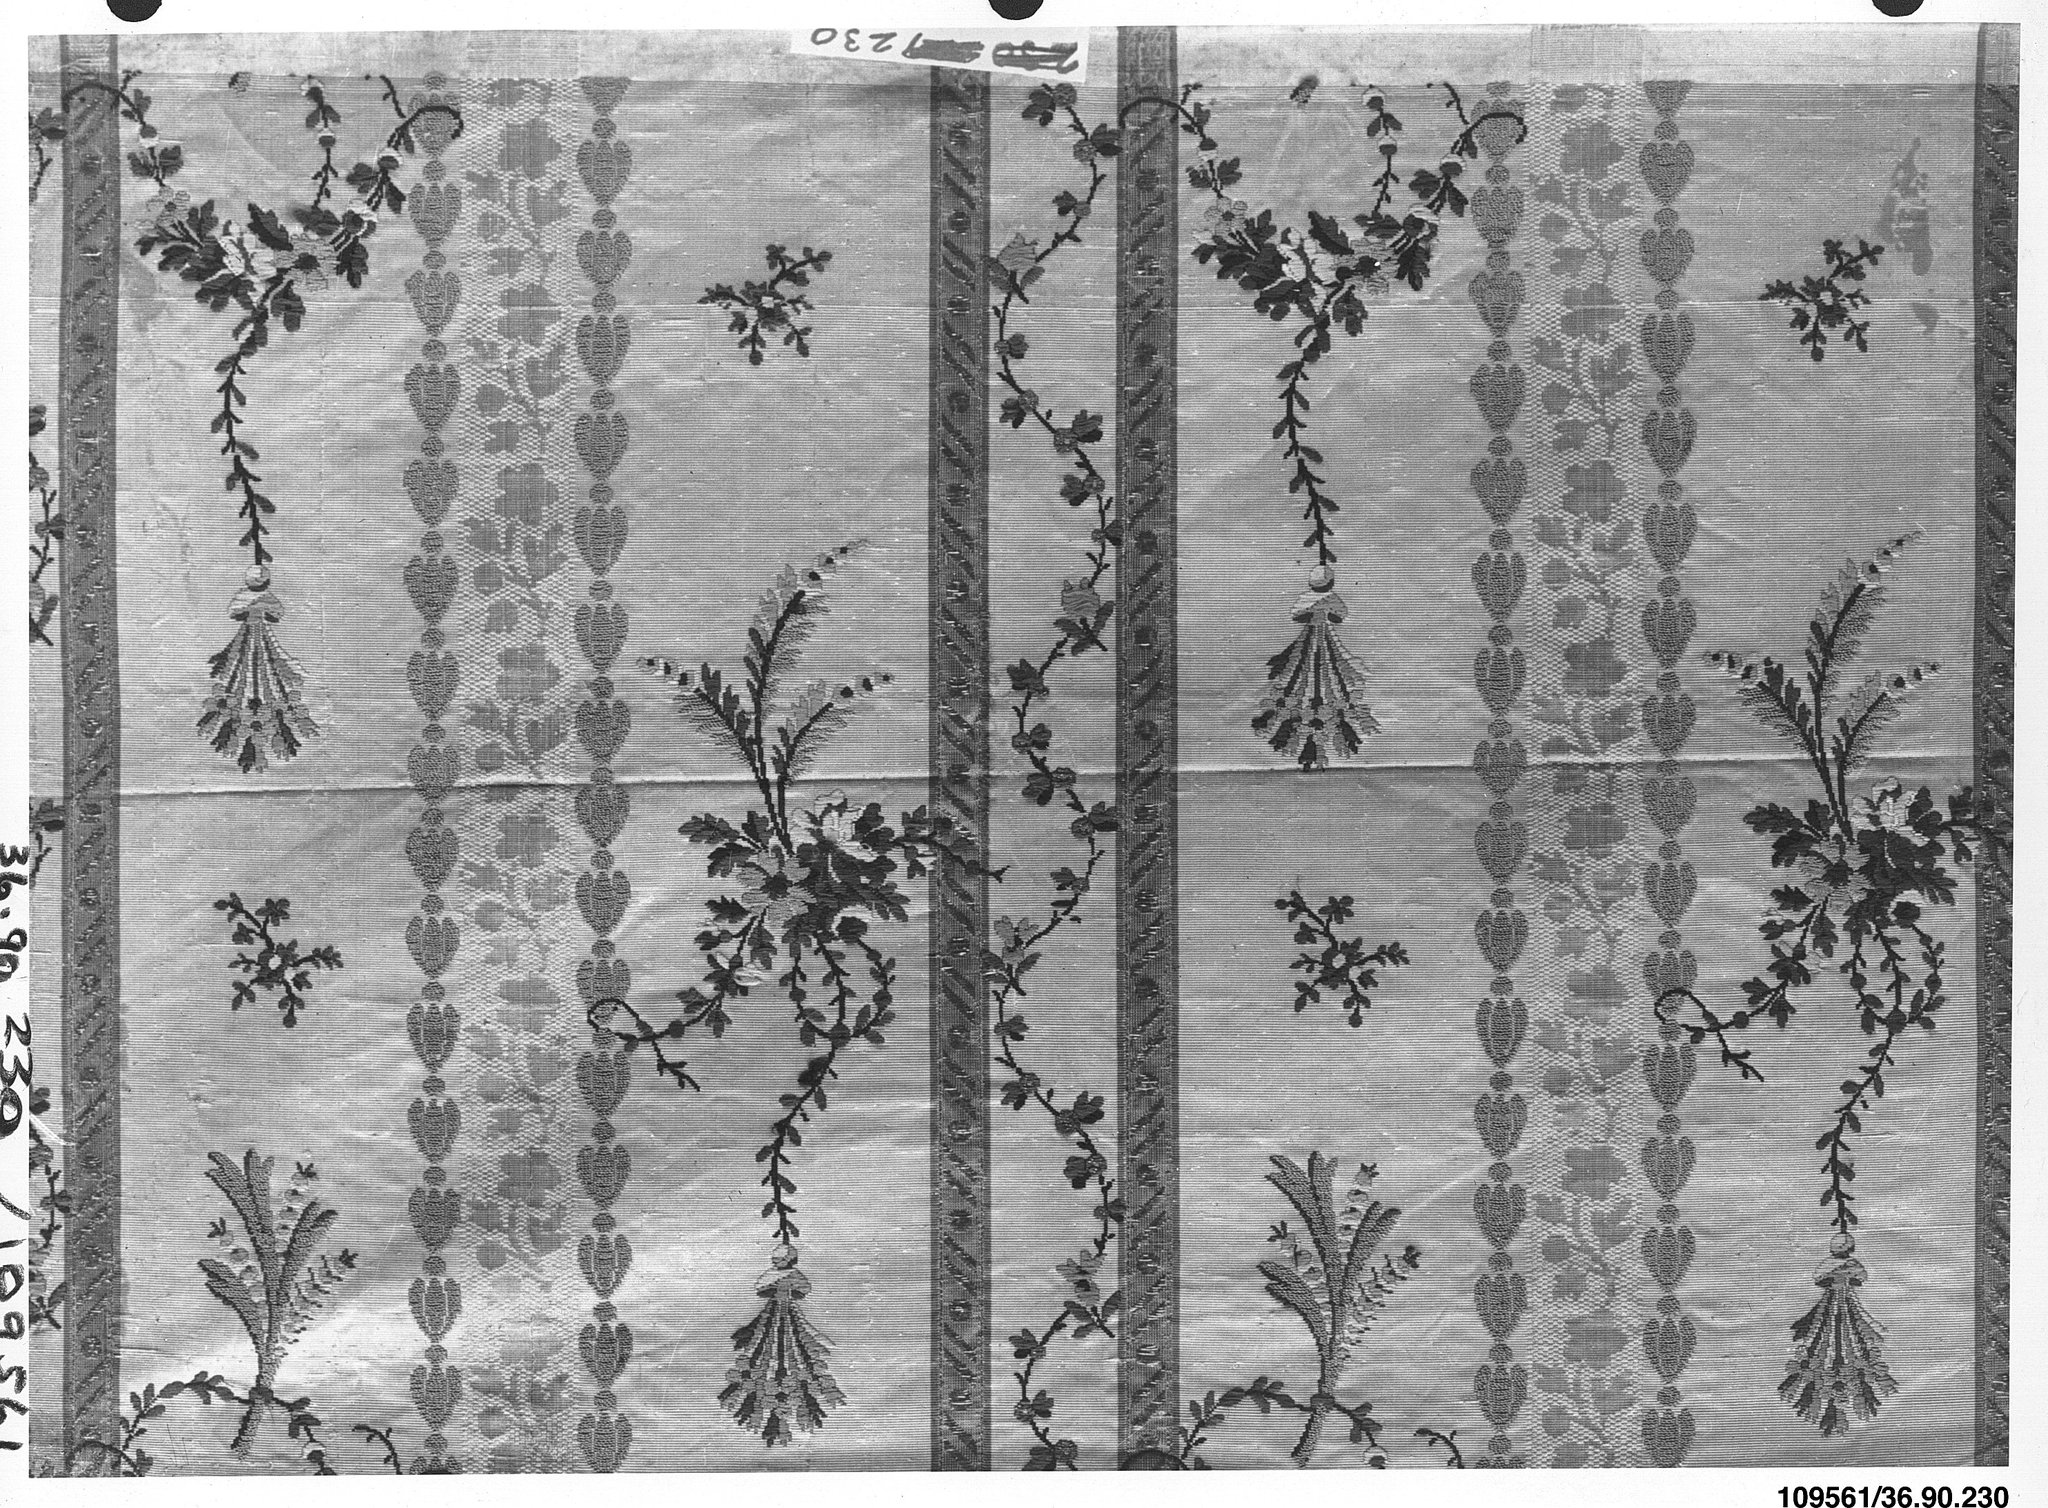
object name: piece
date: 1701-1800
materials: metal thread, silk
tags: flowers,leaves